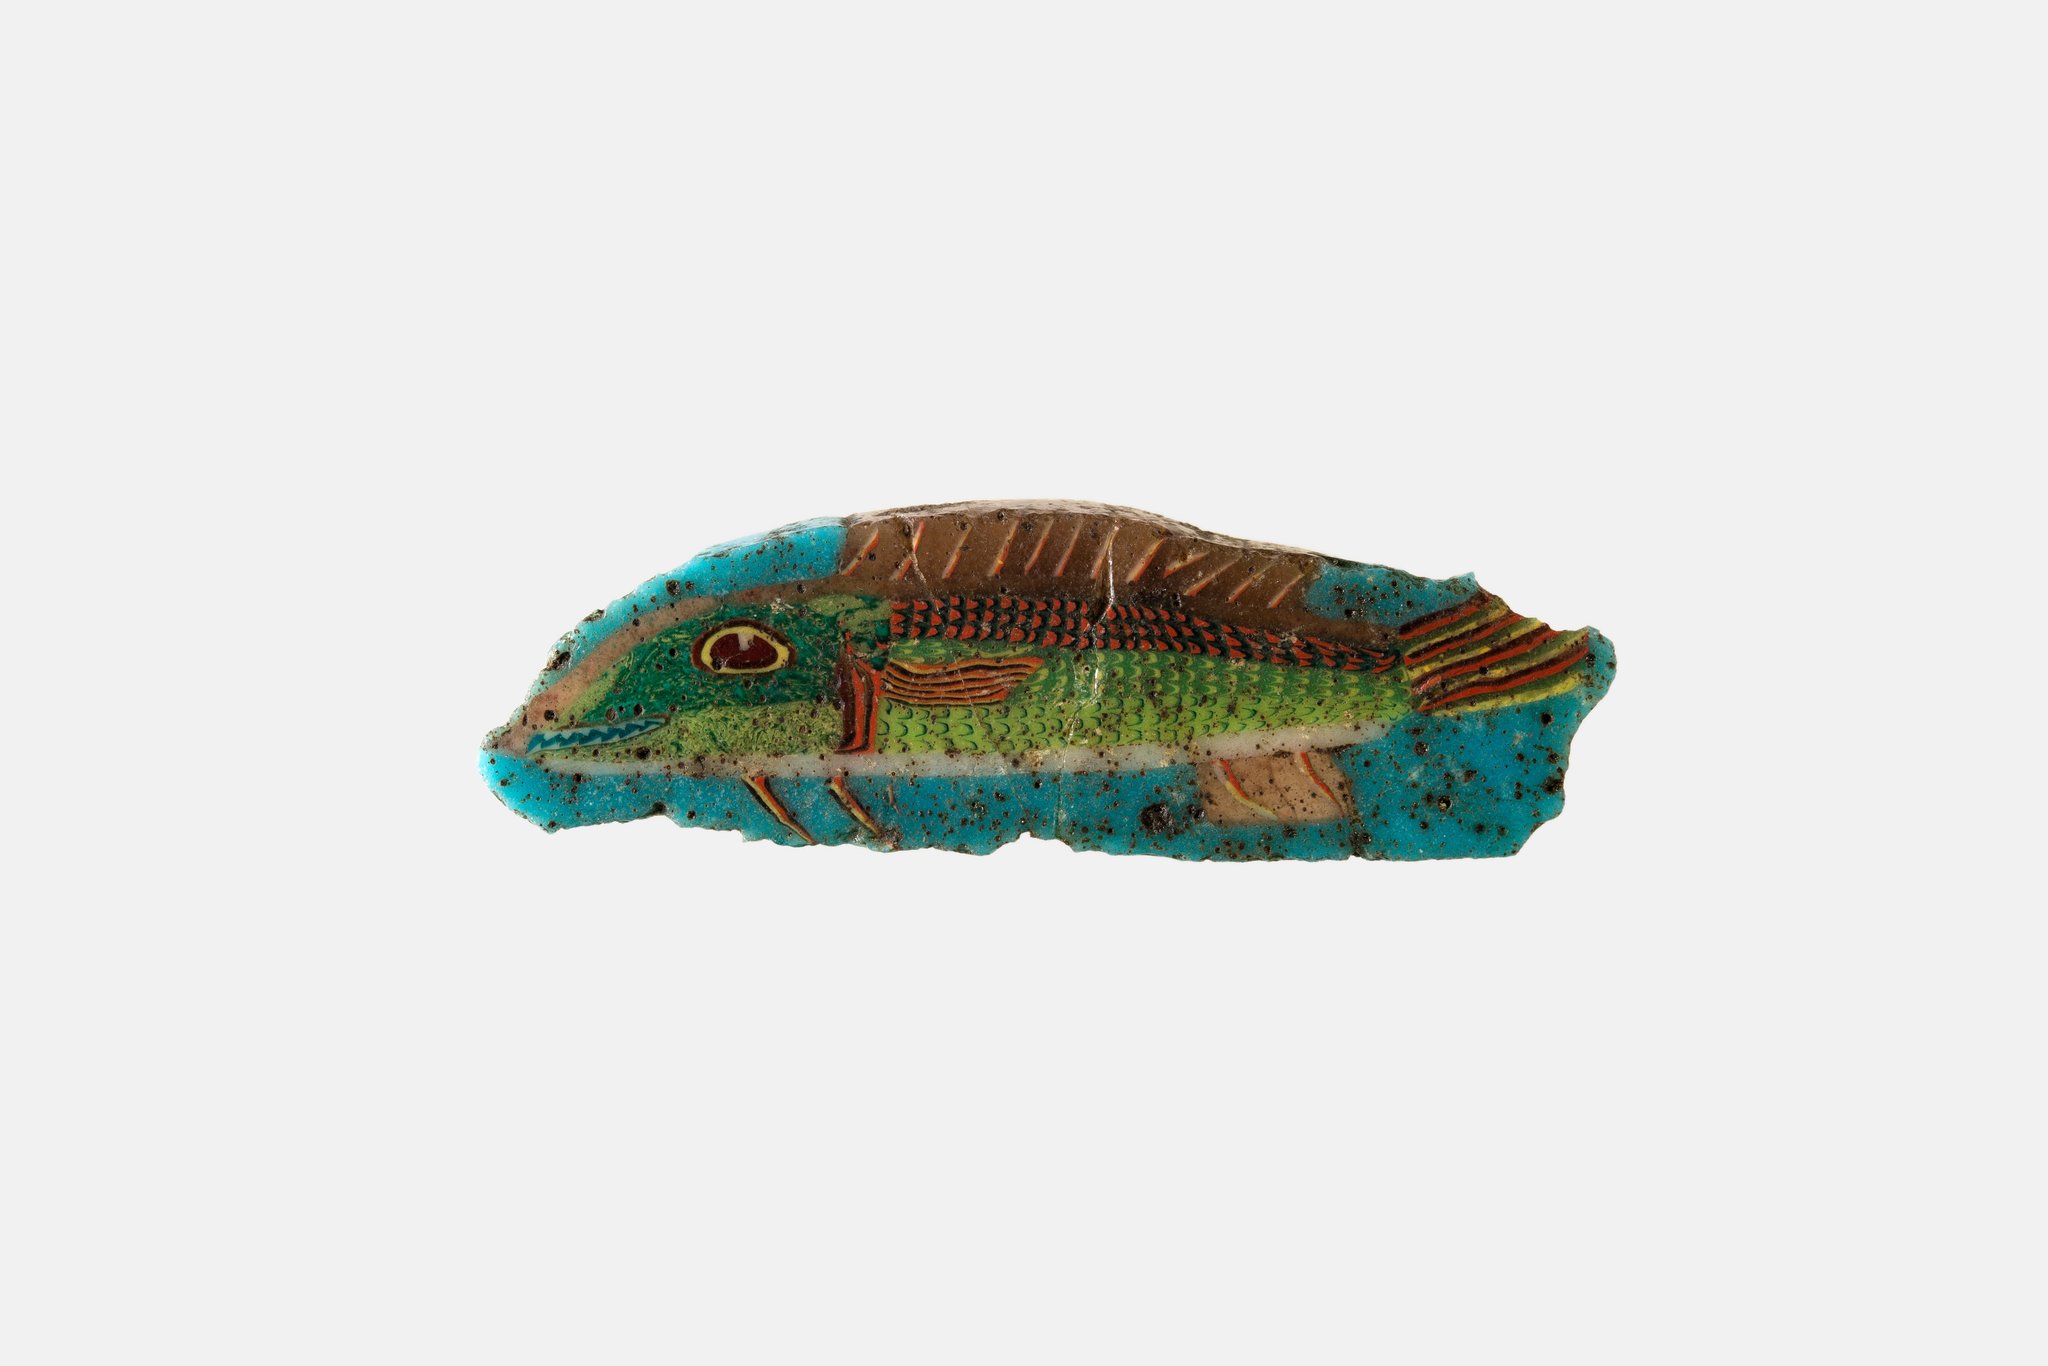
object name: inlay, fish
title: Inlay for Nilotic scene, fish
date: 200 BCE-100 CE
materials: glass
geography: egypt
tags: fish